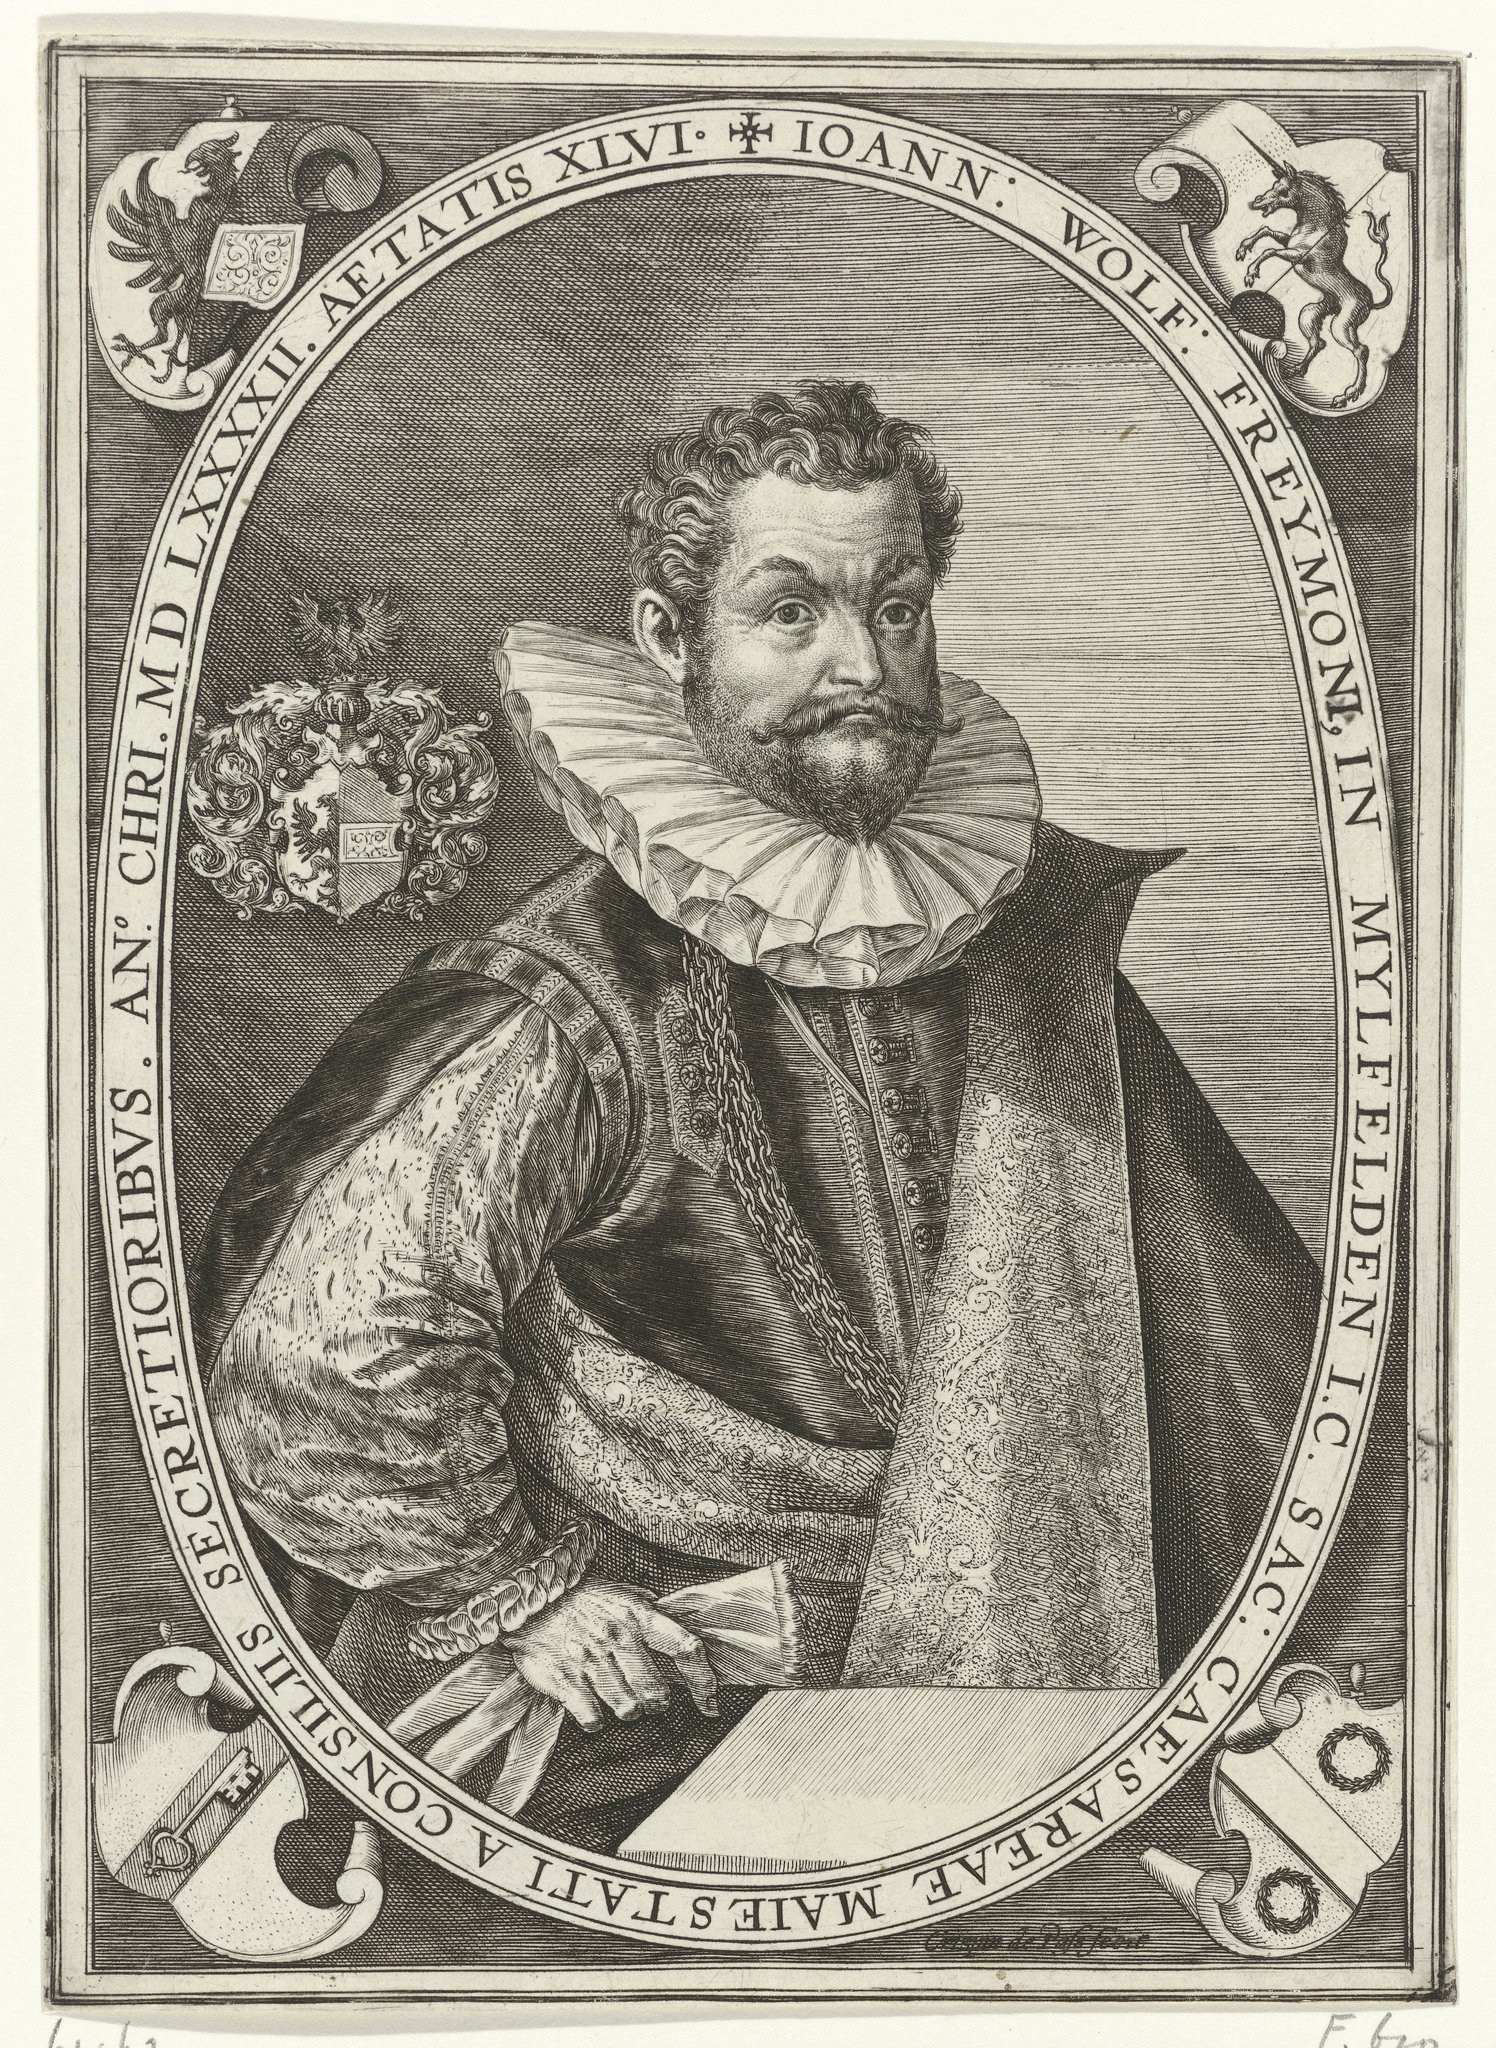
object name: print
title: Portret van Johann Wolfgang Freymann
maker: crispijn van de passe (i)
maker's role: draughtsman, print maker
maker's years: 1564-1637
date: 1592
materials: paper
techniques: engraving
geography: cologne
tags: neck-gear ~ clothing (with name) (+ men's clothes), moustache, clothing for the upper part of the body (doublet) (+ men's clothes), gloves, mittens, etc. (+ men's clothes), sleeves (+ men's clothes), beard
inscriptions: collector's mark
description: Portret van de jurist en kanselier Johann Wolfgang Freymann, op 46-jarige leeftijd. Naast hem zijn wapenschild. In de hoeken vier wapenschilden. In het randschrift van de omlijsting de naam, functie en leeftijd van de geportretteerde in het Latijn.